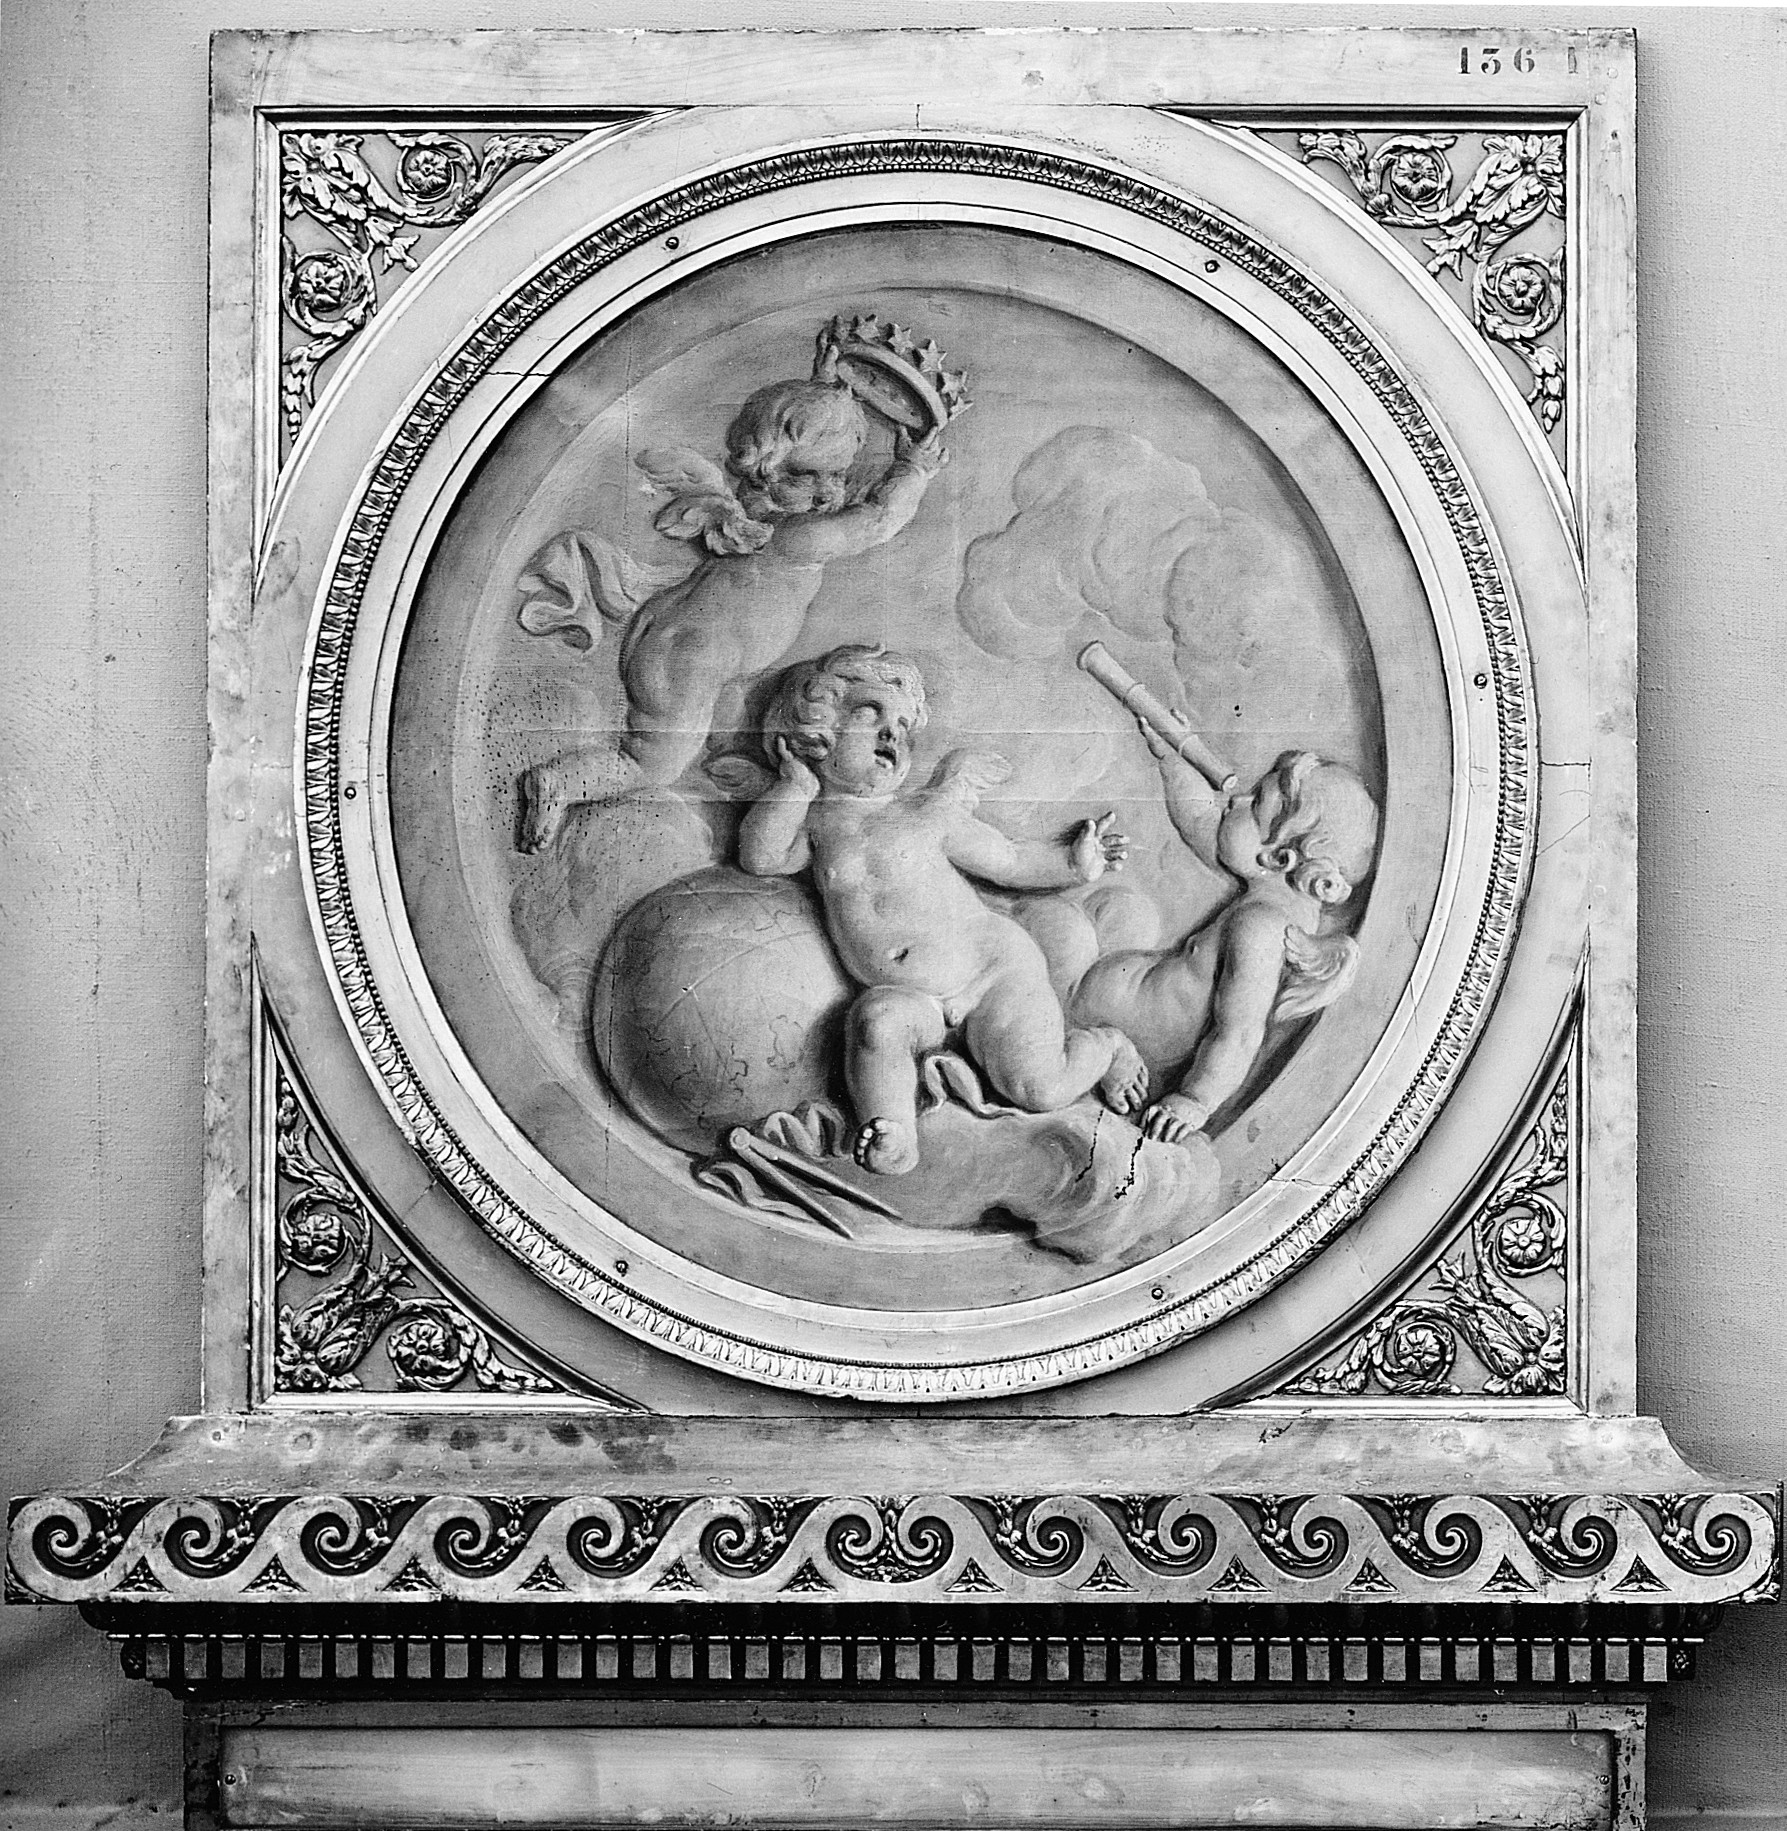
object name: overdoor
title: Astronomy (one of a pair)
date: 1770-1790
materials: canvas, oil, wood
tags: putti,globes